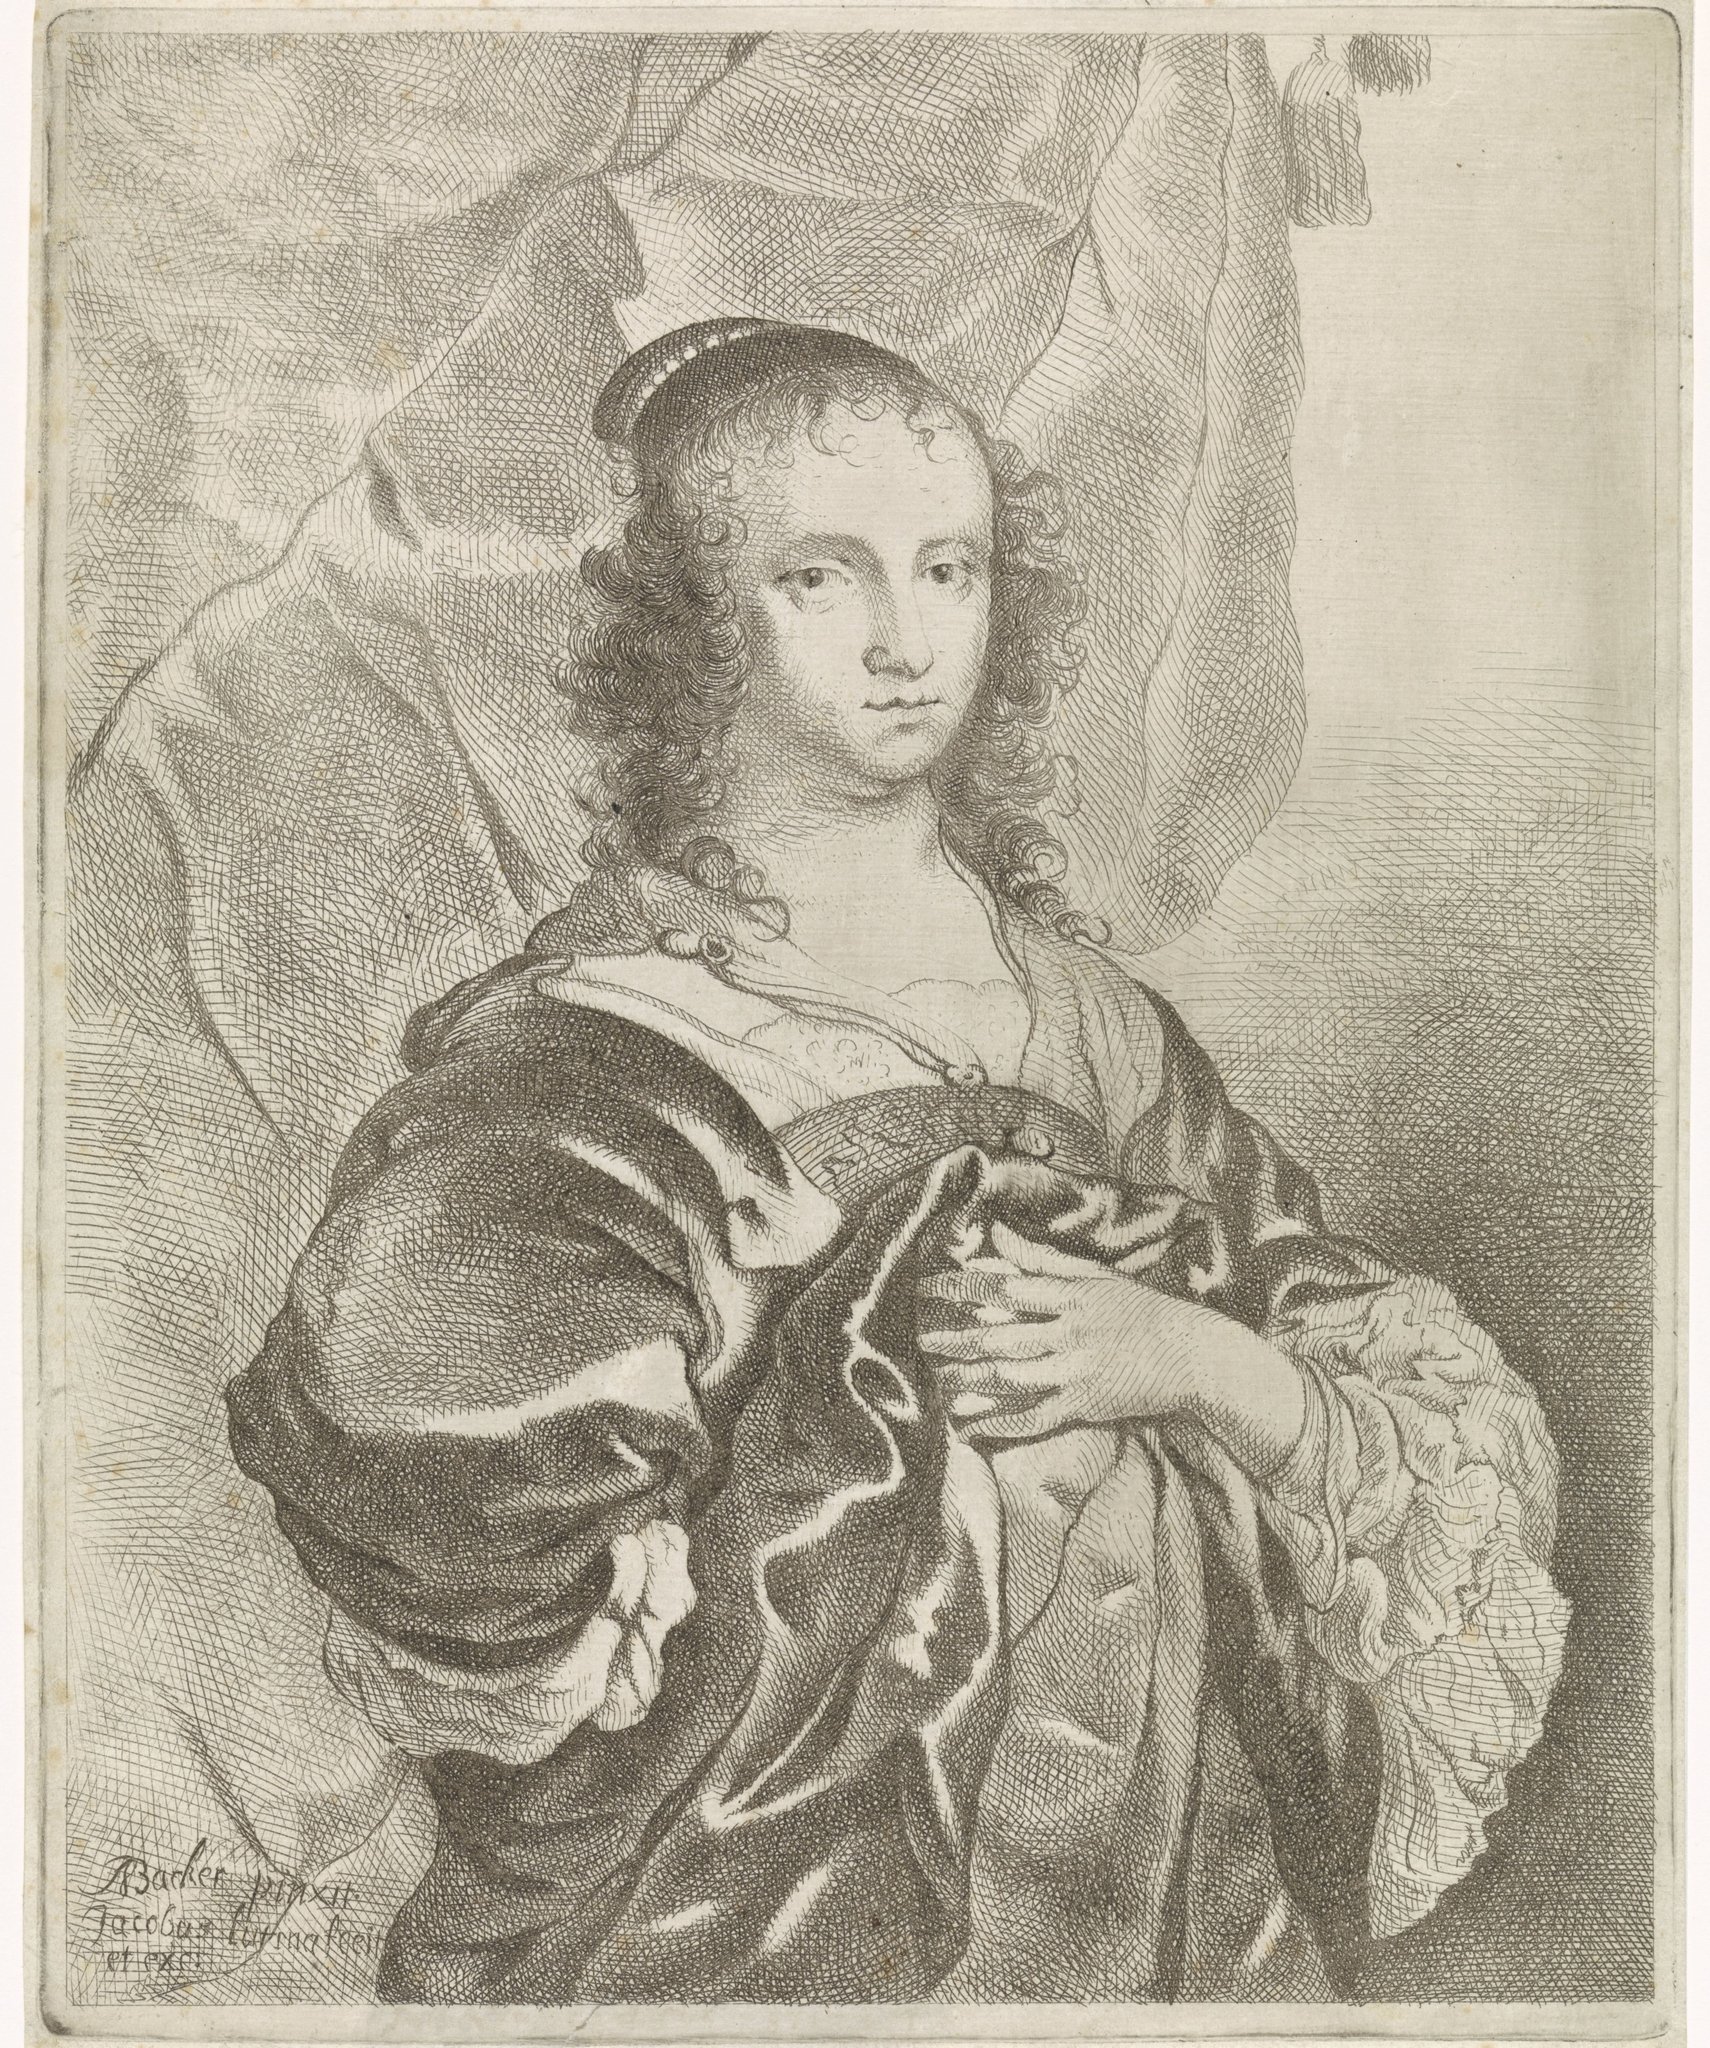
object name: print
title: Portret van Geertruida Hasselaer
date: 1645-1654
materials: paper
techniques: etching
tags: geertruida hasselaer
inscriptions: collector's mark: Lugt 2233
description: Portret van Geertruida Hasselaer, echtgenote van Cornelis van Werkhoven, raad in de Vroedschap te Utrecht.